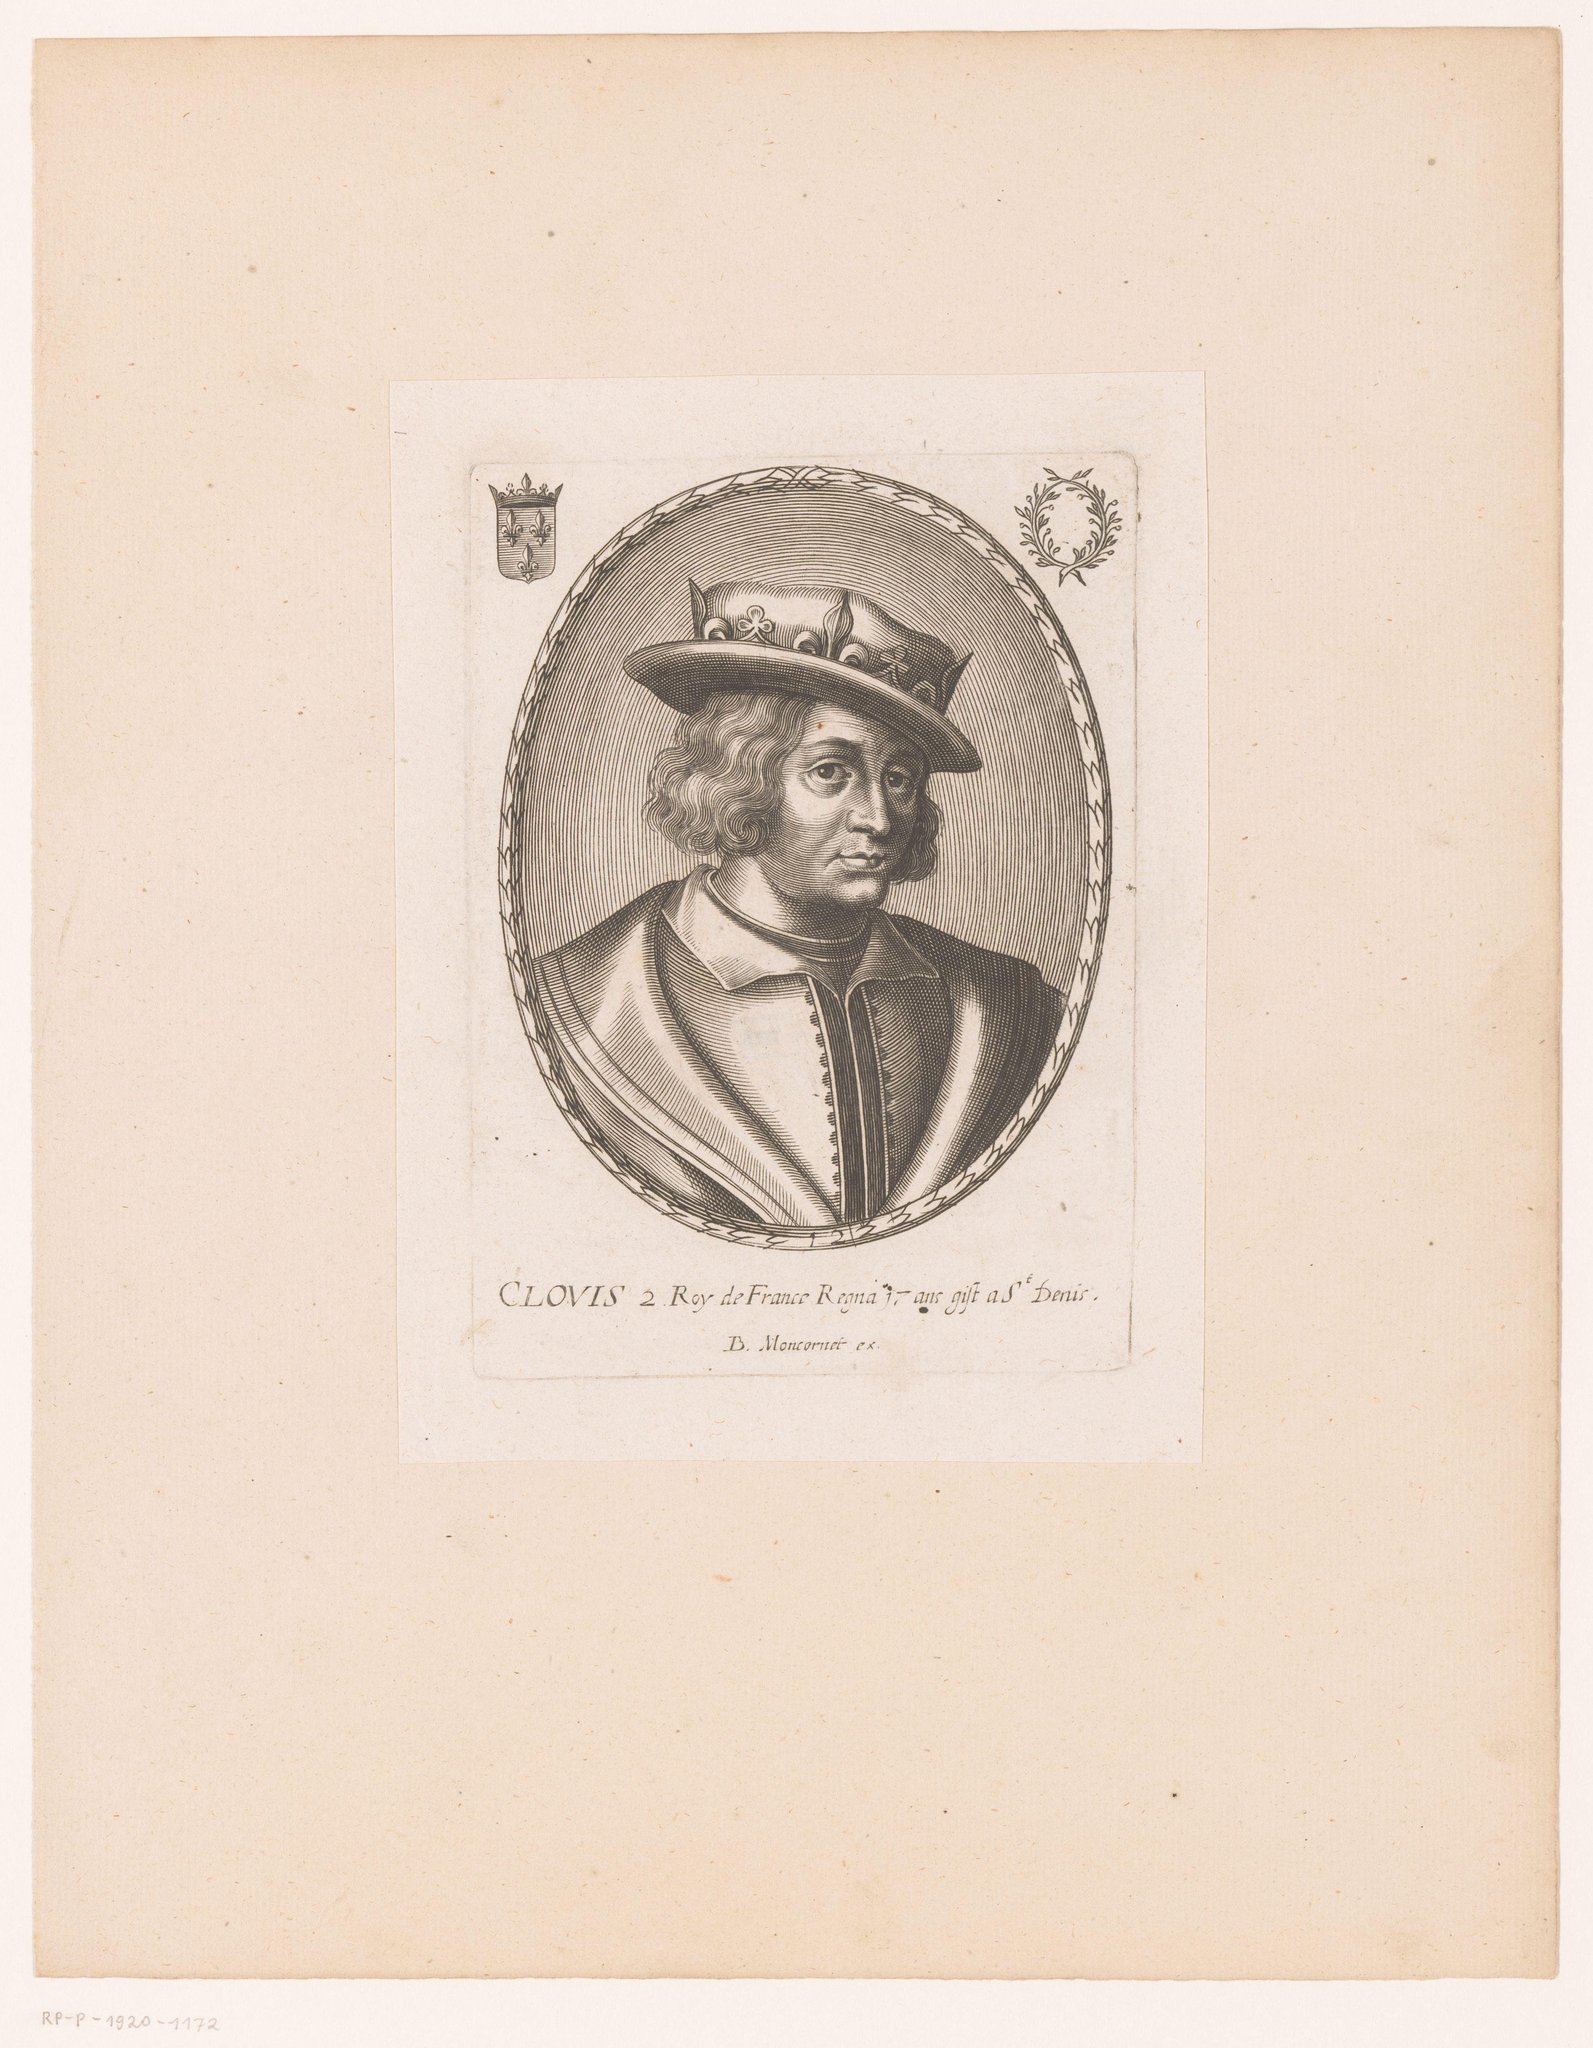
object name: print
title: Portret van Clovis II, koning der Franken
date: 1610-1668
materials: paper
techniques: engraving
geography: paris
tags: historical persons, king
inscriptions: collector's mark: Lugt 2228